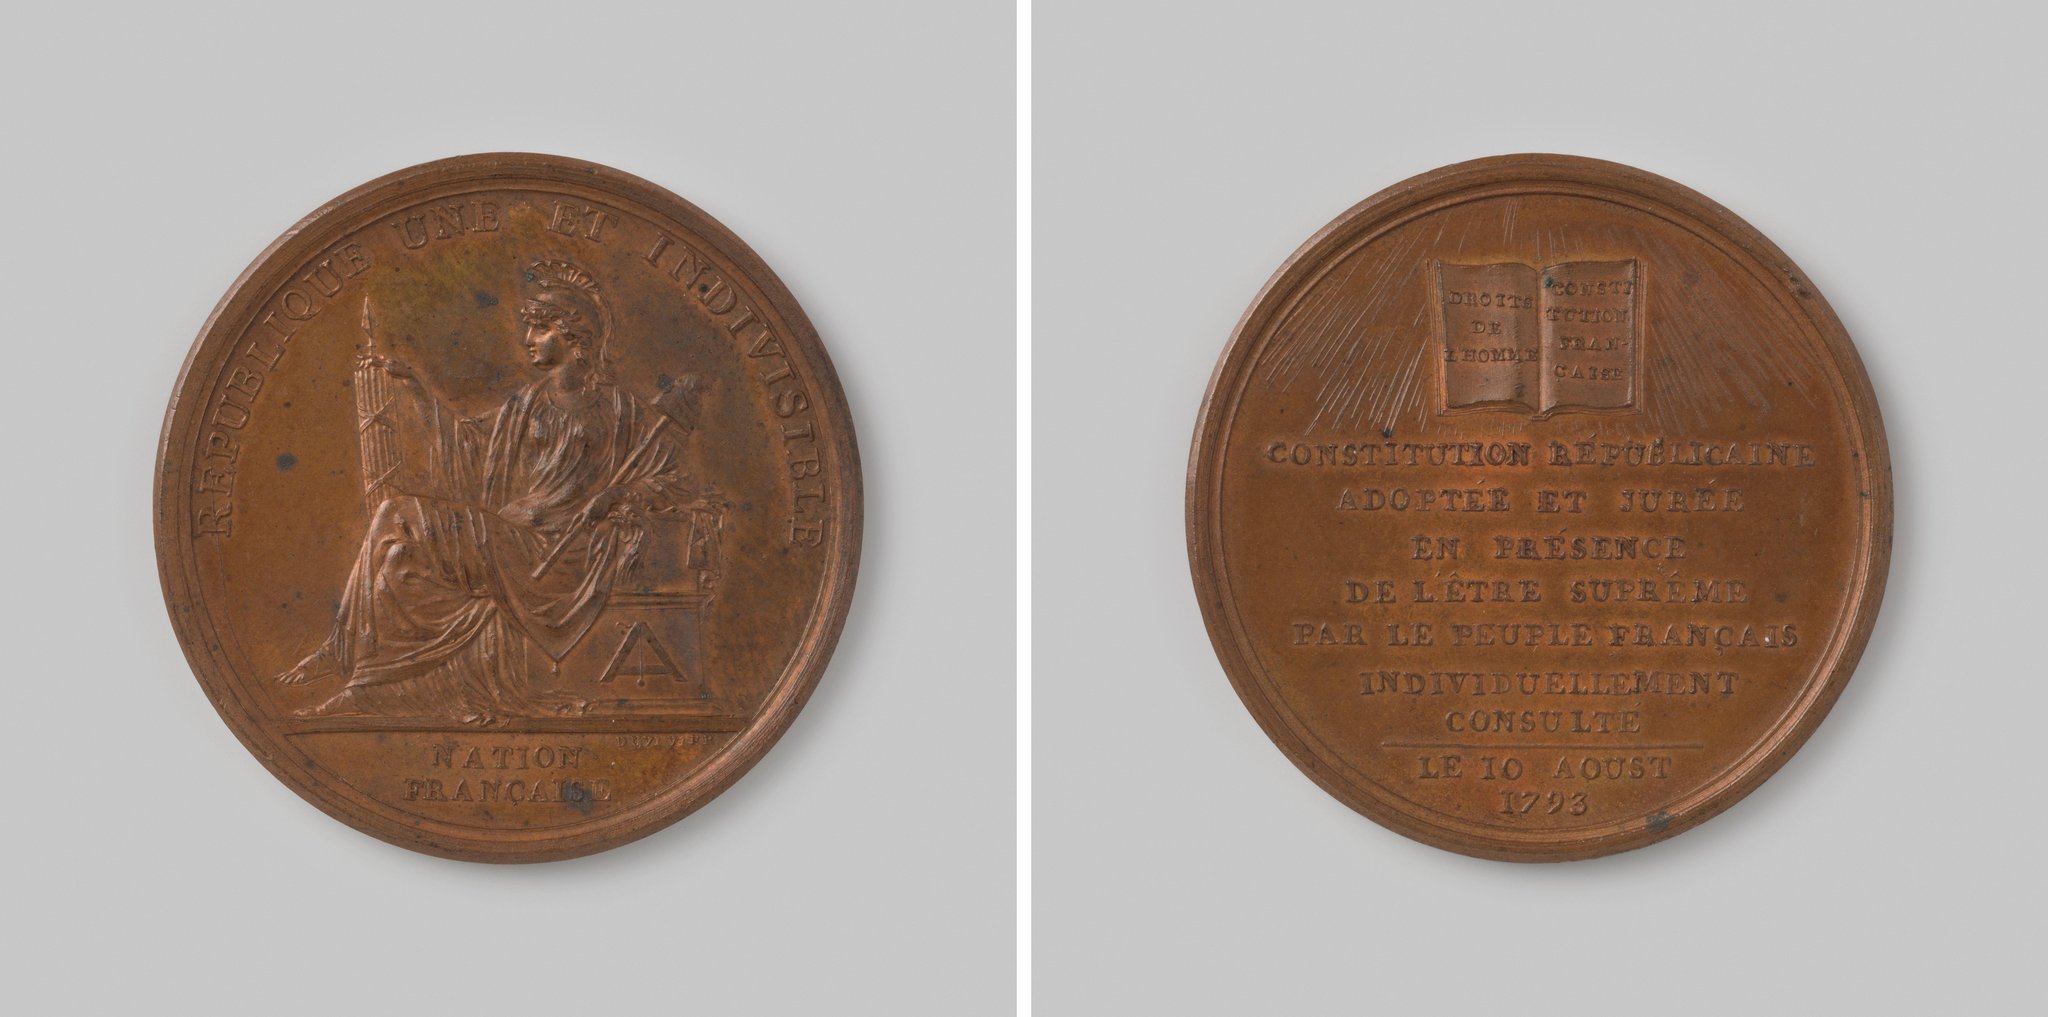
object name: history medal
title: Eedsaflegging op de Franse Republikeinse Grondwet 1793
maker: claude duvivier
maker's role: silversmith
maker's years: 1688-1747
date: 1793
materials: copper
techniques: striking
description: Koperen penning, op de voorzijde Frankrijk als vrouw met fasces en scepter met vijheidshoed op een troon versierd met schietlood, met omschrift en afsnedetekst, op de keerzijde een zonbestraald opengeslagen boek waaronder negen regels tekst.